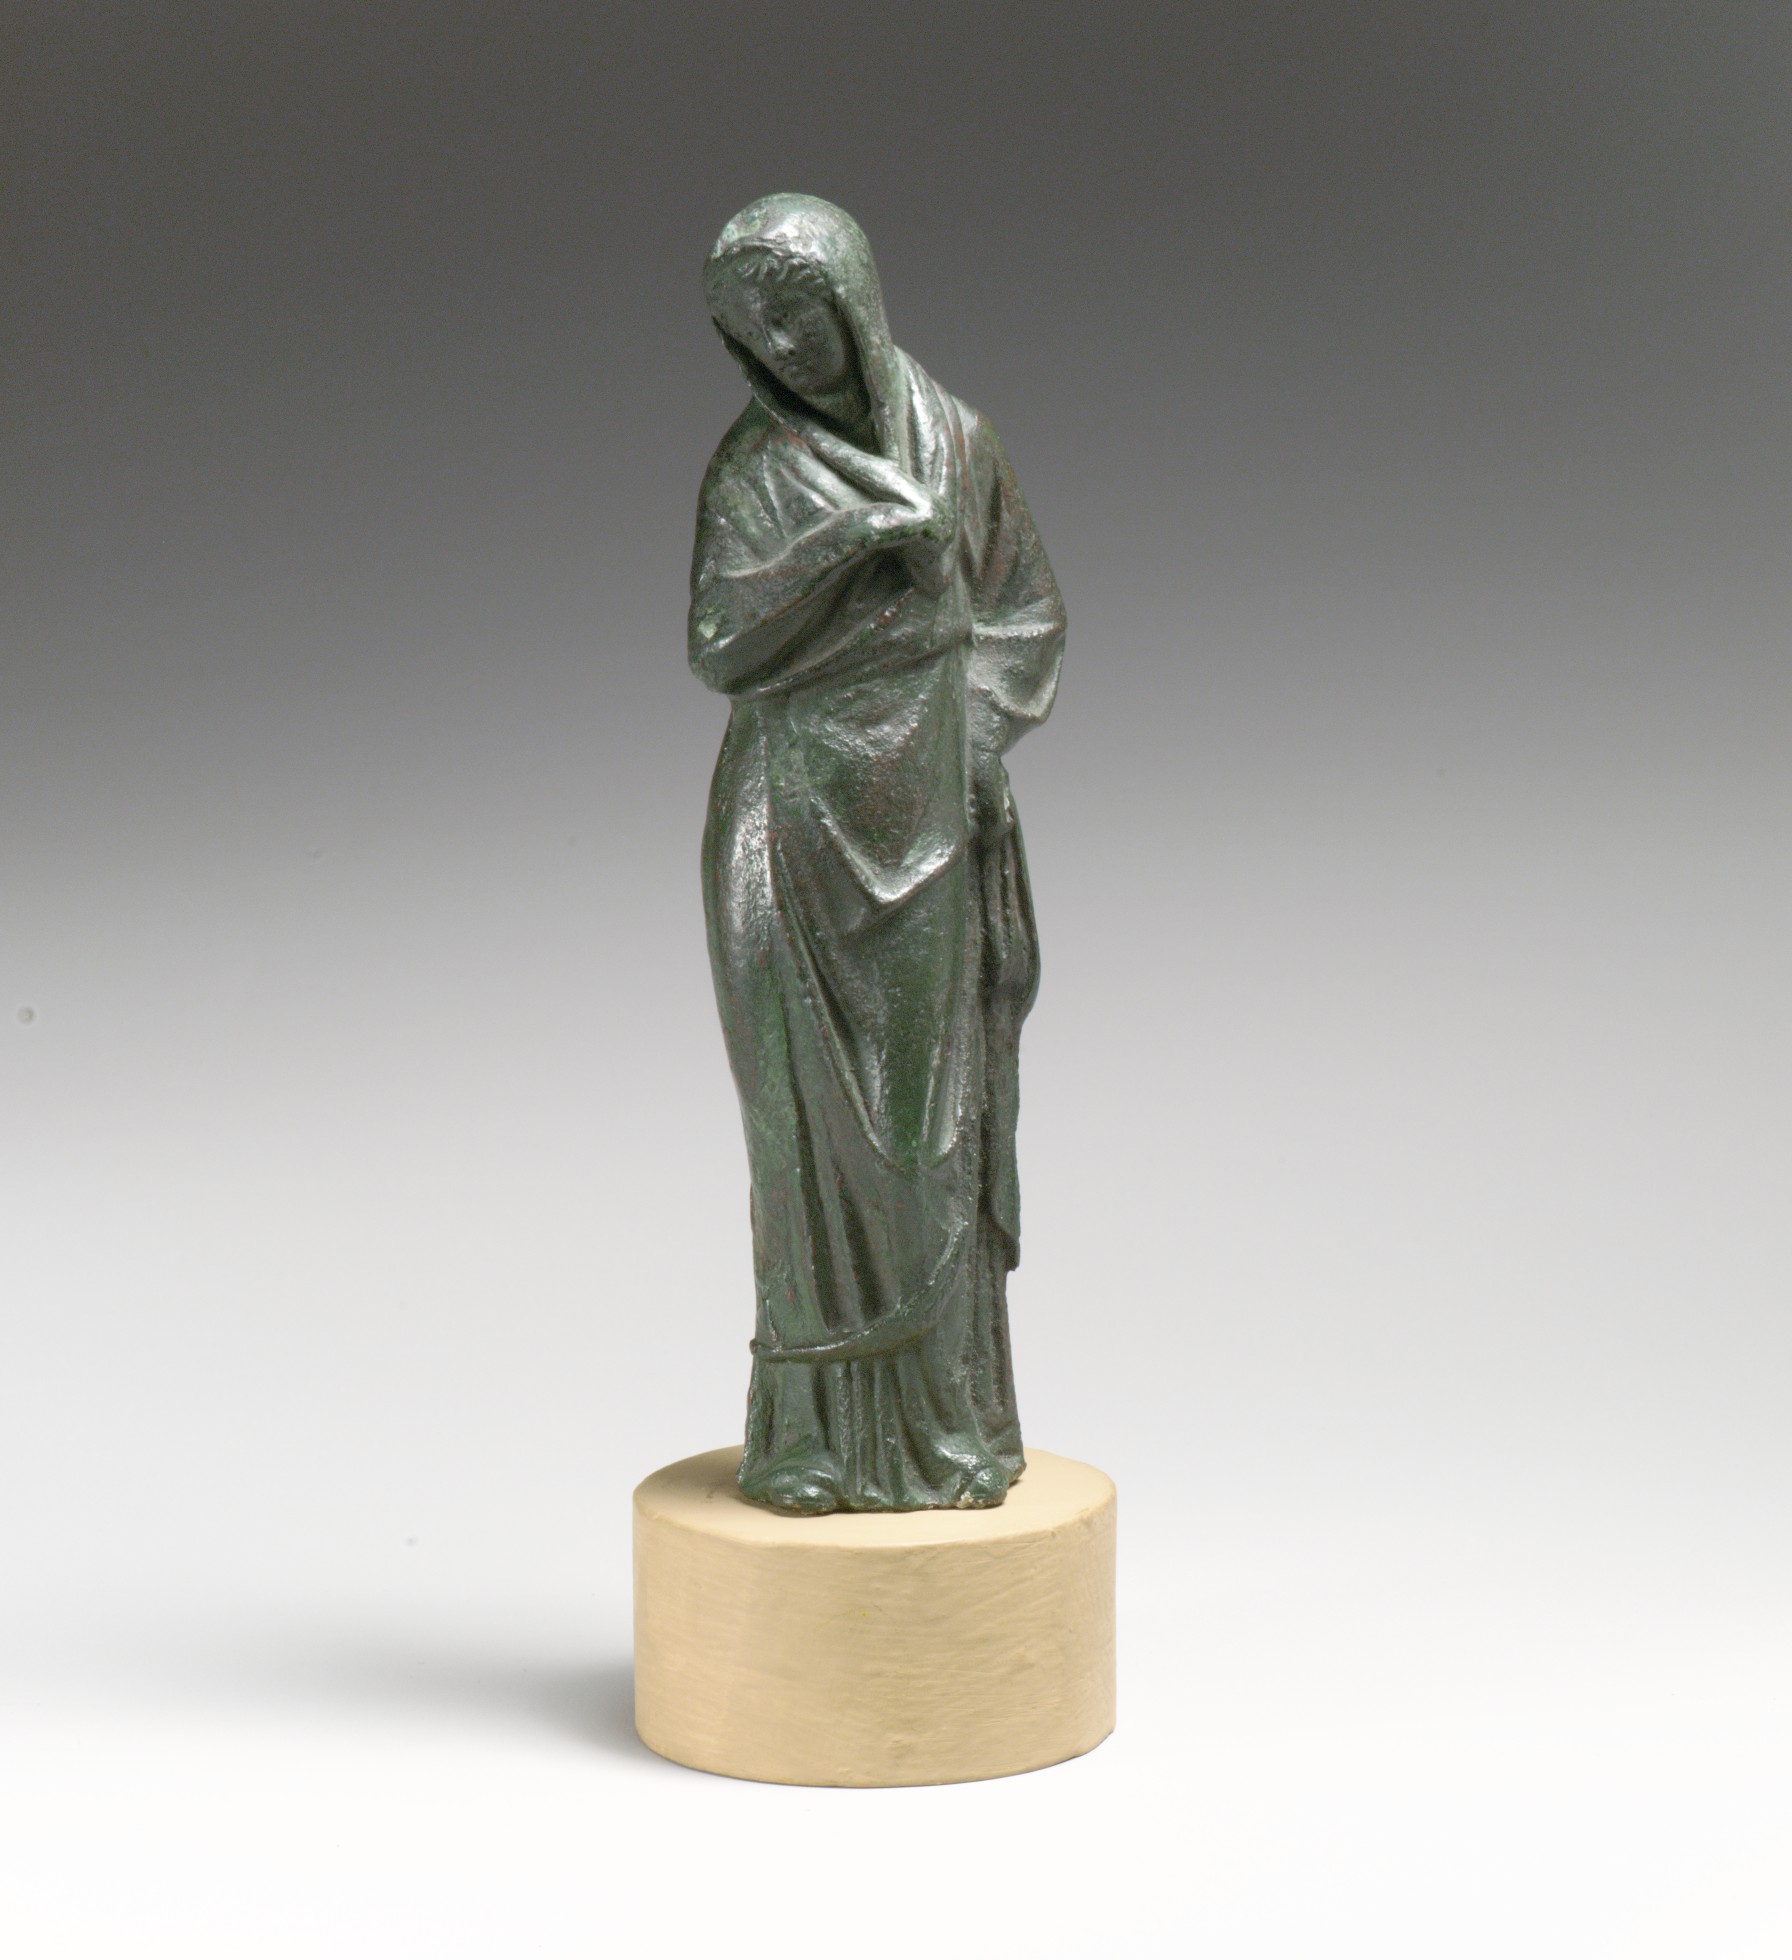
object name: statuette of a woman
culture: roman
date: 1-200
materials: bronze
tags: women